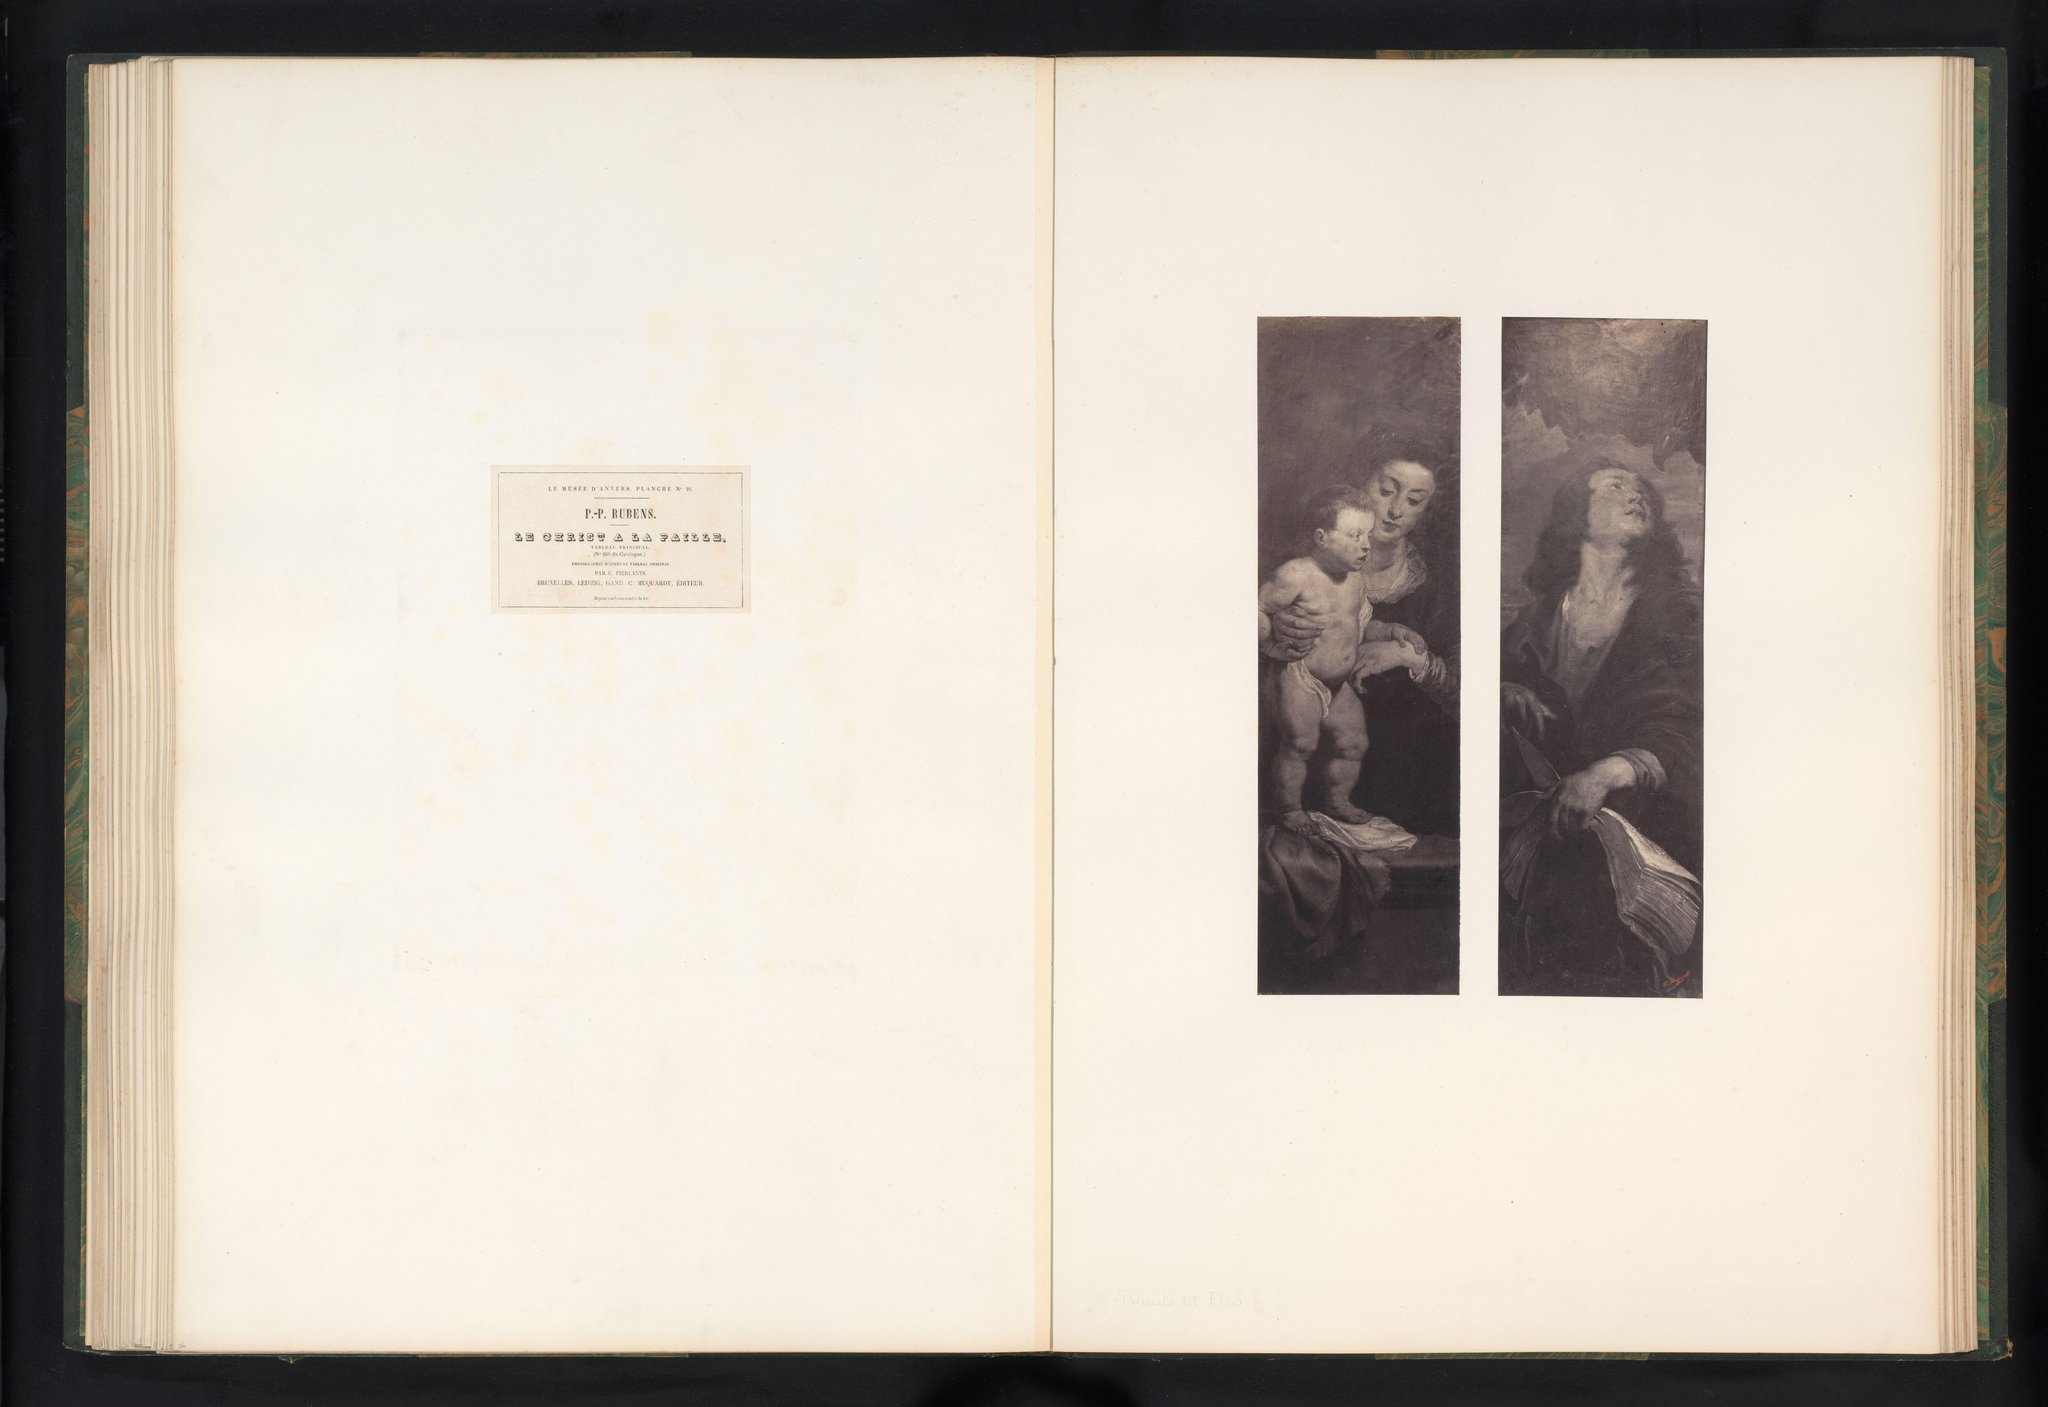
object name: reproduction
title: Fotoreproducties van Madonna en de Heilige Johannes door Peter Paul Rubens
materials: photographic support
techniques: albumen print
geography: brussels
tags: the apostle john the evangelist; possible attributes: book, cauldron, chalice with snake, eagle, palm, scroll, mary standing (or half-length), the christ-child in front of her, close to her bosom; standing